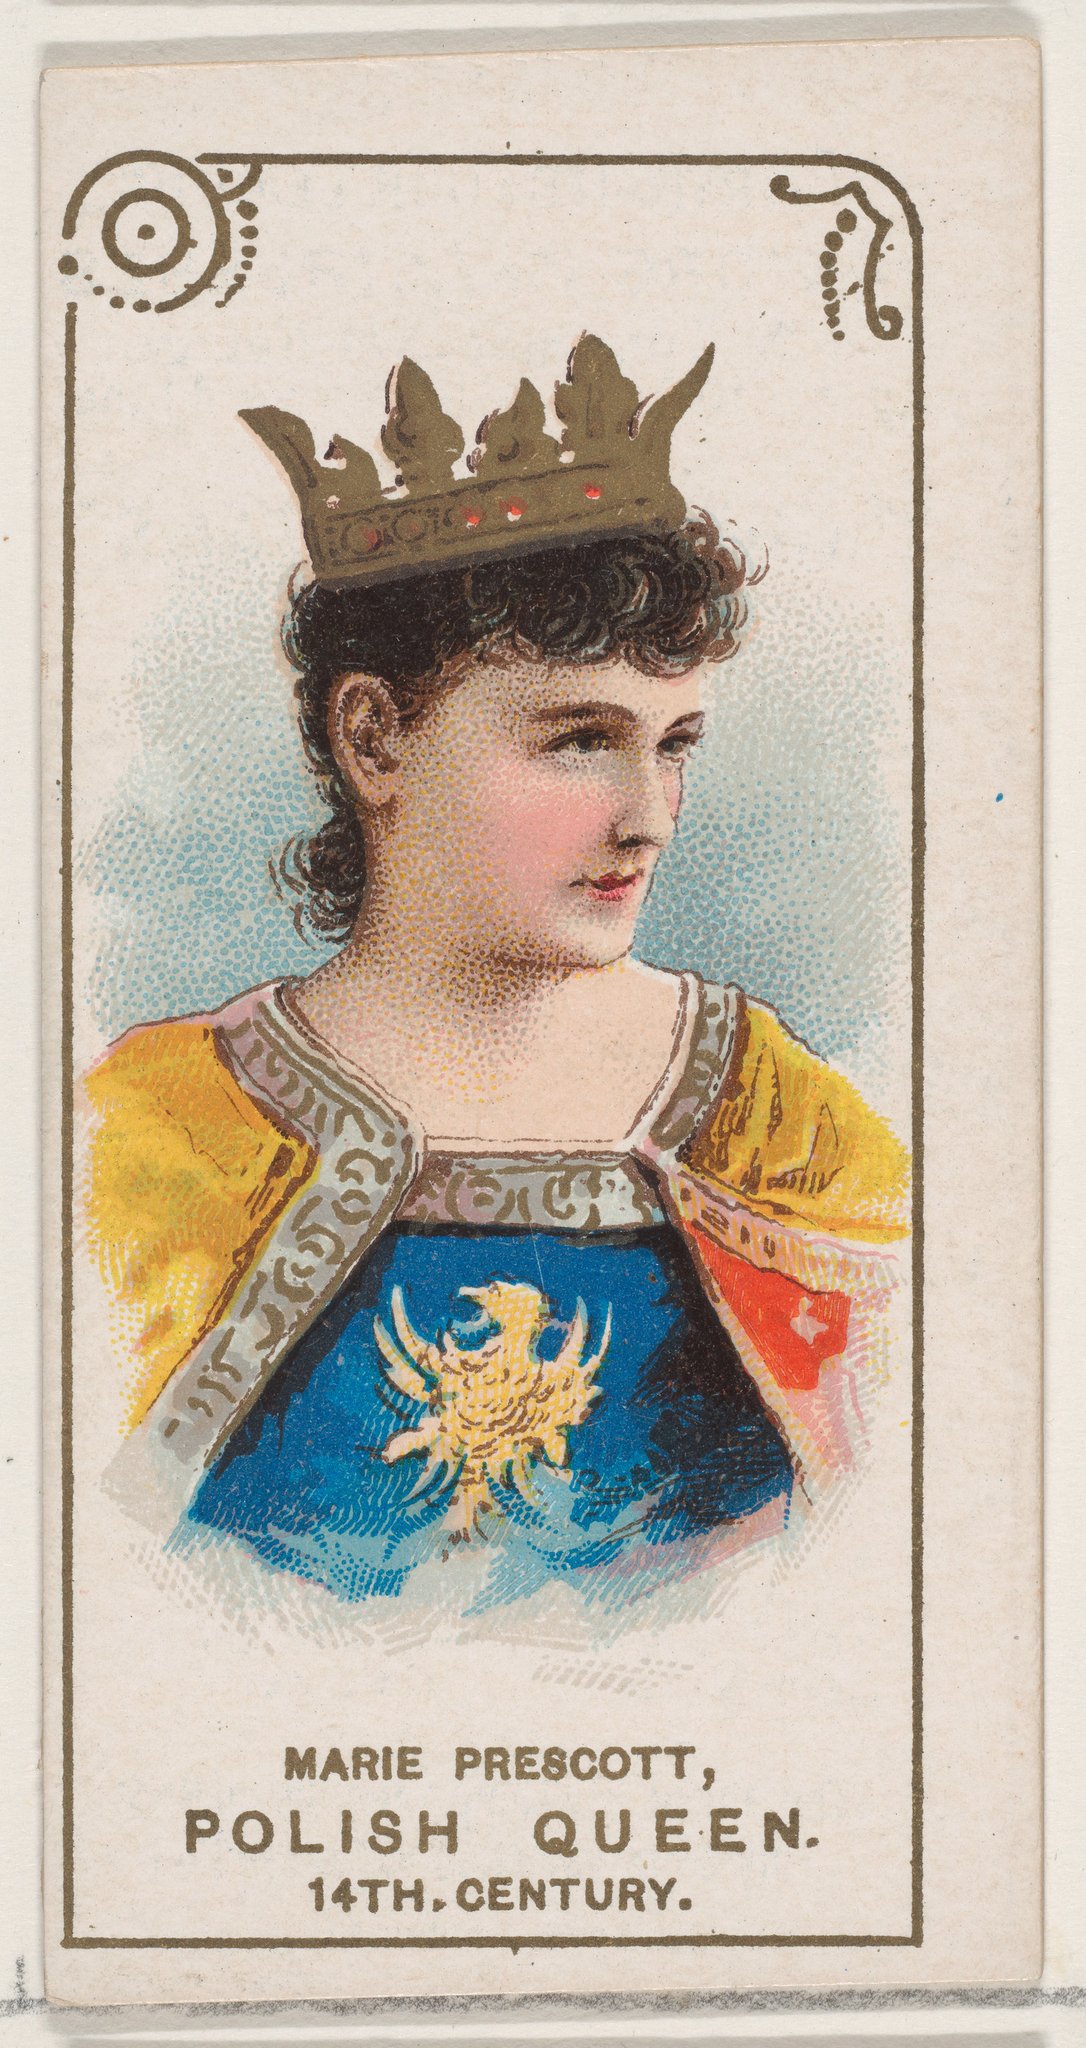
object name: print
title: Marie Prescott Dressed as Polish Queen of the 14th Century, from the set Actors and Actresses, Second Series (N71) for Duke brand cigarettes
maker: w. duke, sons & co.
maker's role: publisher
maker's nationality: american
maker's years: 1870-1920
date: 1888-1890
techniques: color lithograph